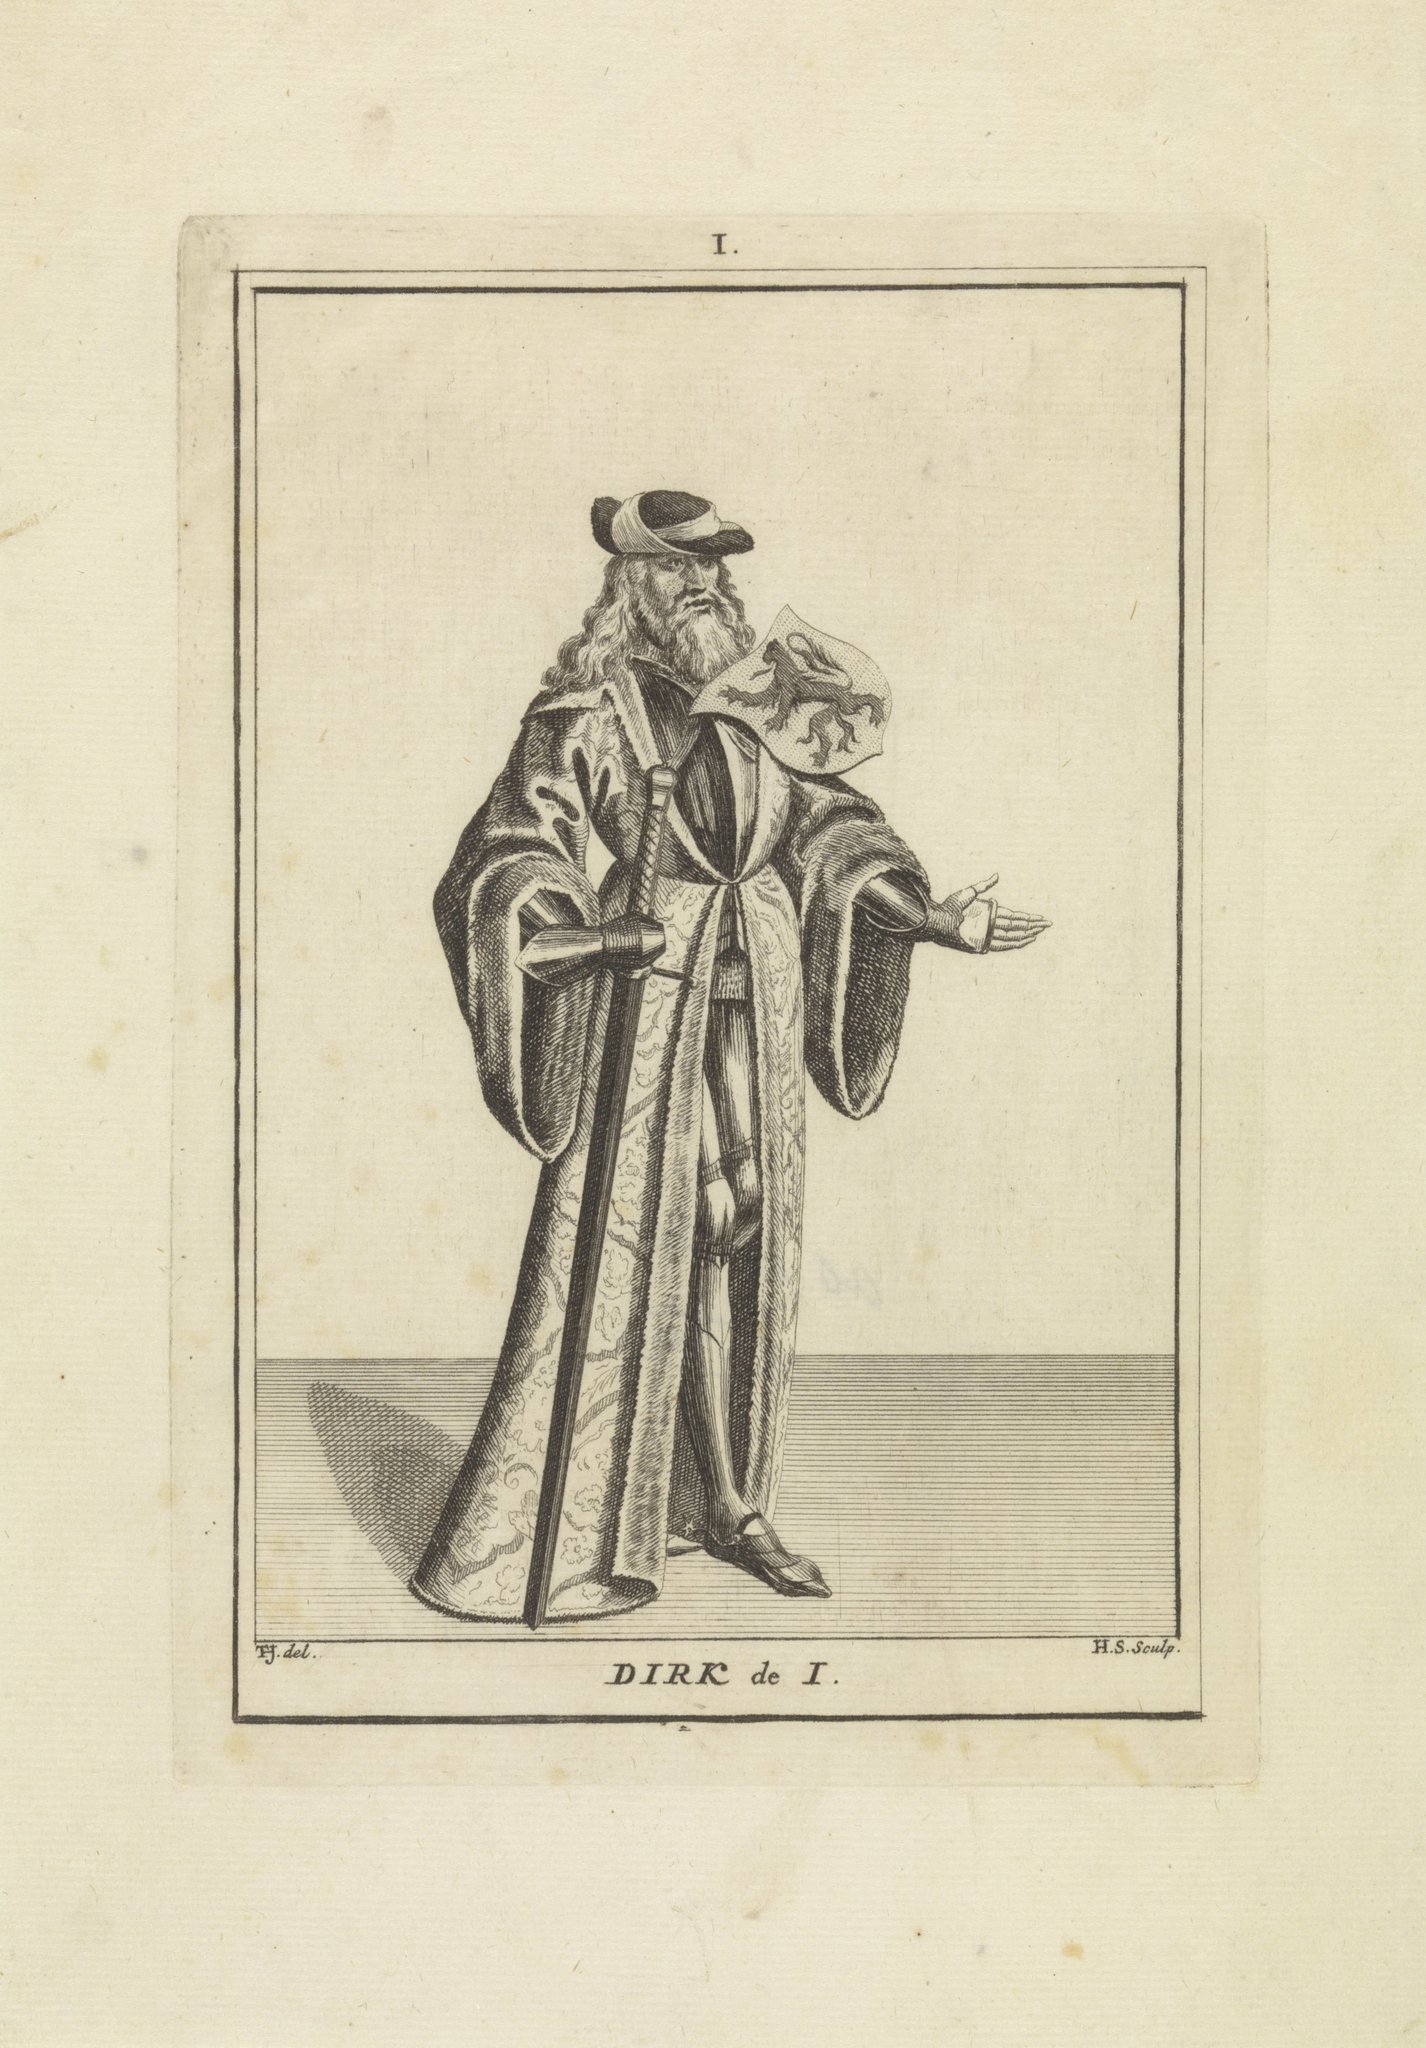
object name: book illustration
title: Portret van Dirk I, graaf van Holland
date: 1745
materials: paper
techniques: etching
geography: haarlem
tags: nobility and patriciate; chivalry, knighthood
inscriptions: collector's mark: Lugt 2228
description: Titelpagina voor: Langendyk, Pieter. De Graaven van Holland, in jaardichten beschreven door Pieter Langendyk. Verykt met alle de beeldtenissen dier prinsen, naauwkeurig getekend naar de echte aloude tafereelen of de zaal van't raadhuis der stad Haarlem. Haarlem: J. Bosch, 1745.